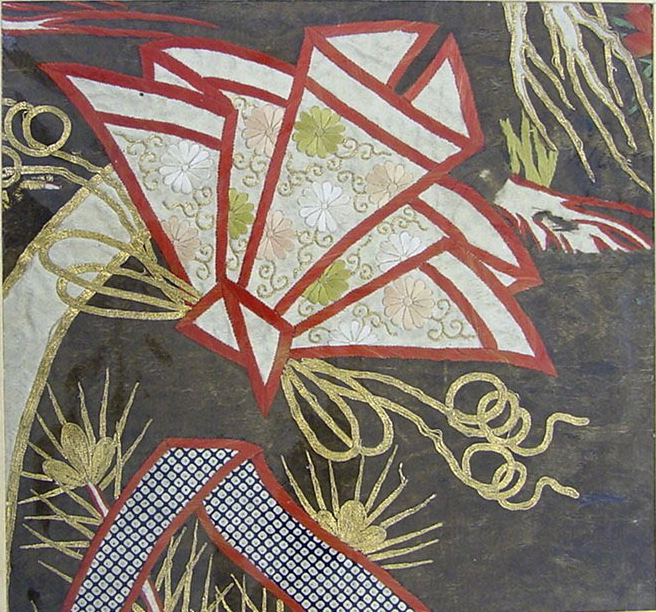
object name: piece from a kosode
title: Piece from a Kosode with Congratulatory Decoration (noshi)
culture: japanese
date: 1615-1868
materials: metal thread, silk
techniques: damask, dyeing, embroidery, resist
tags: flowers